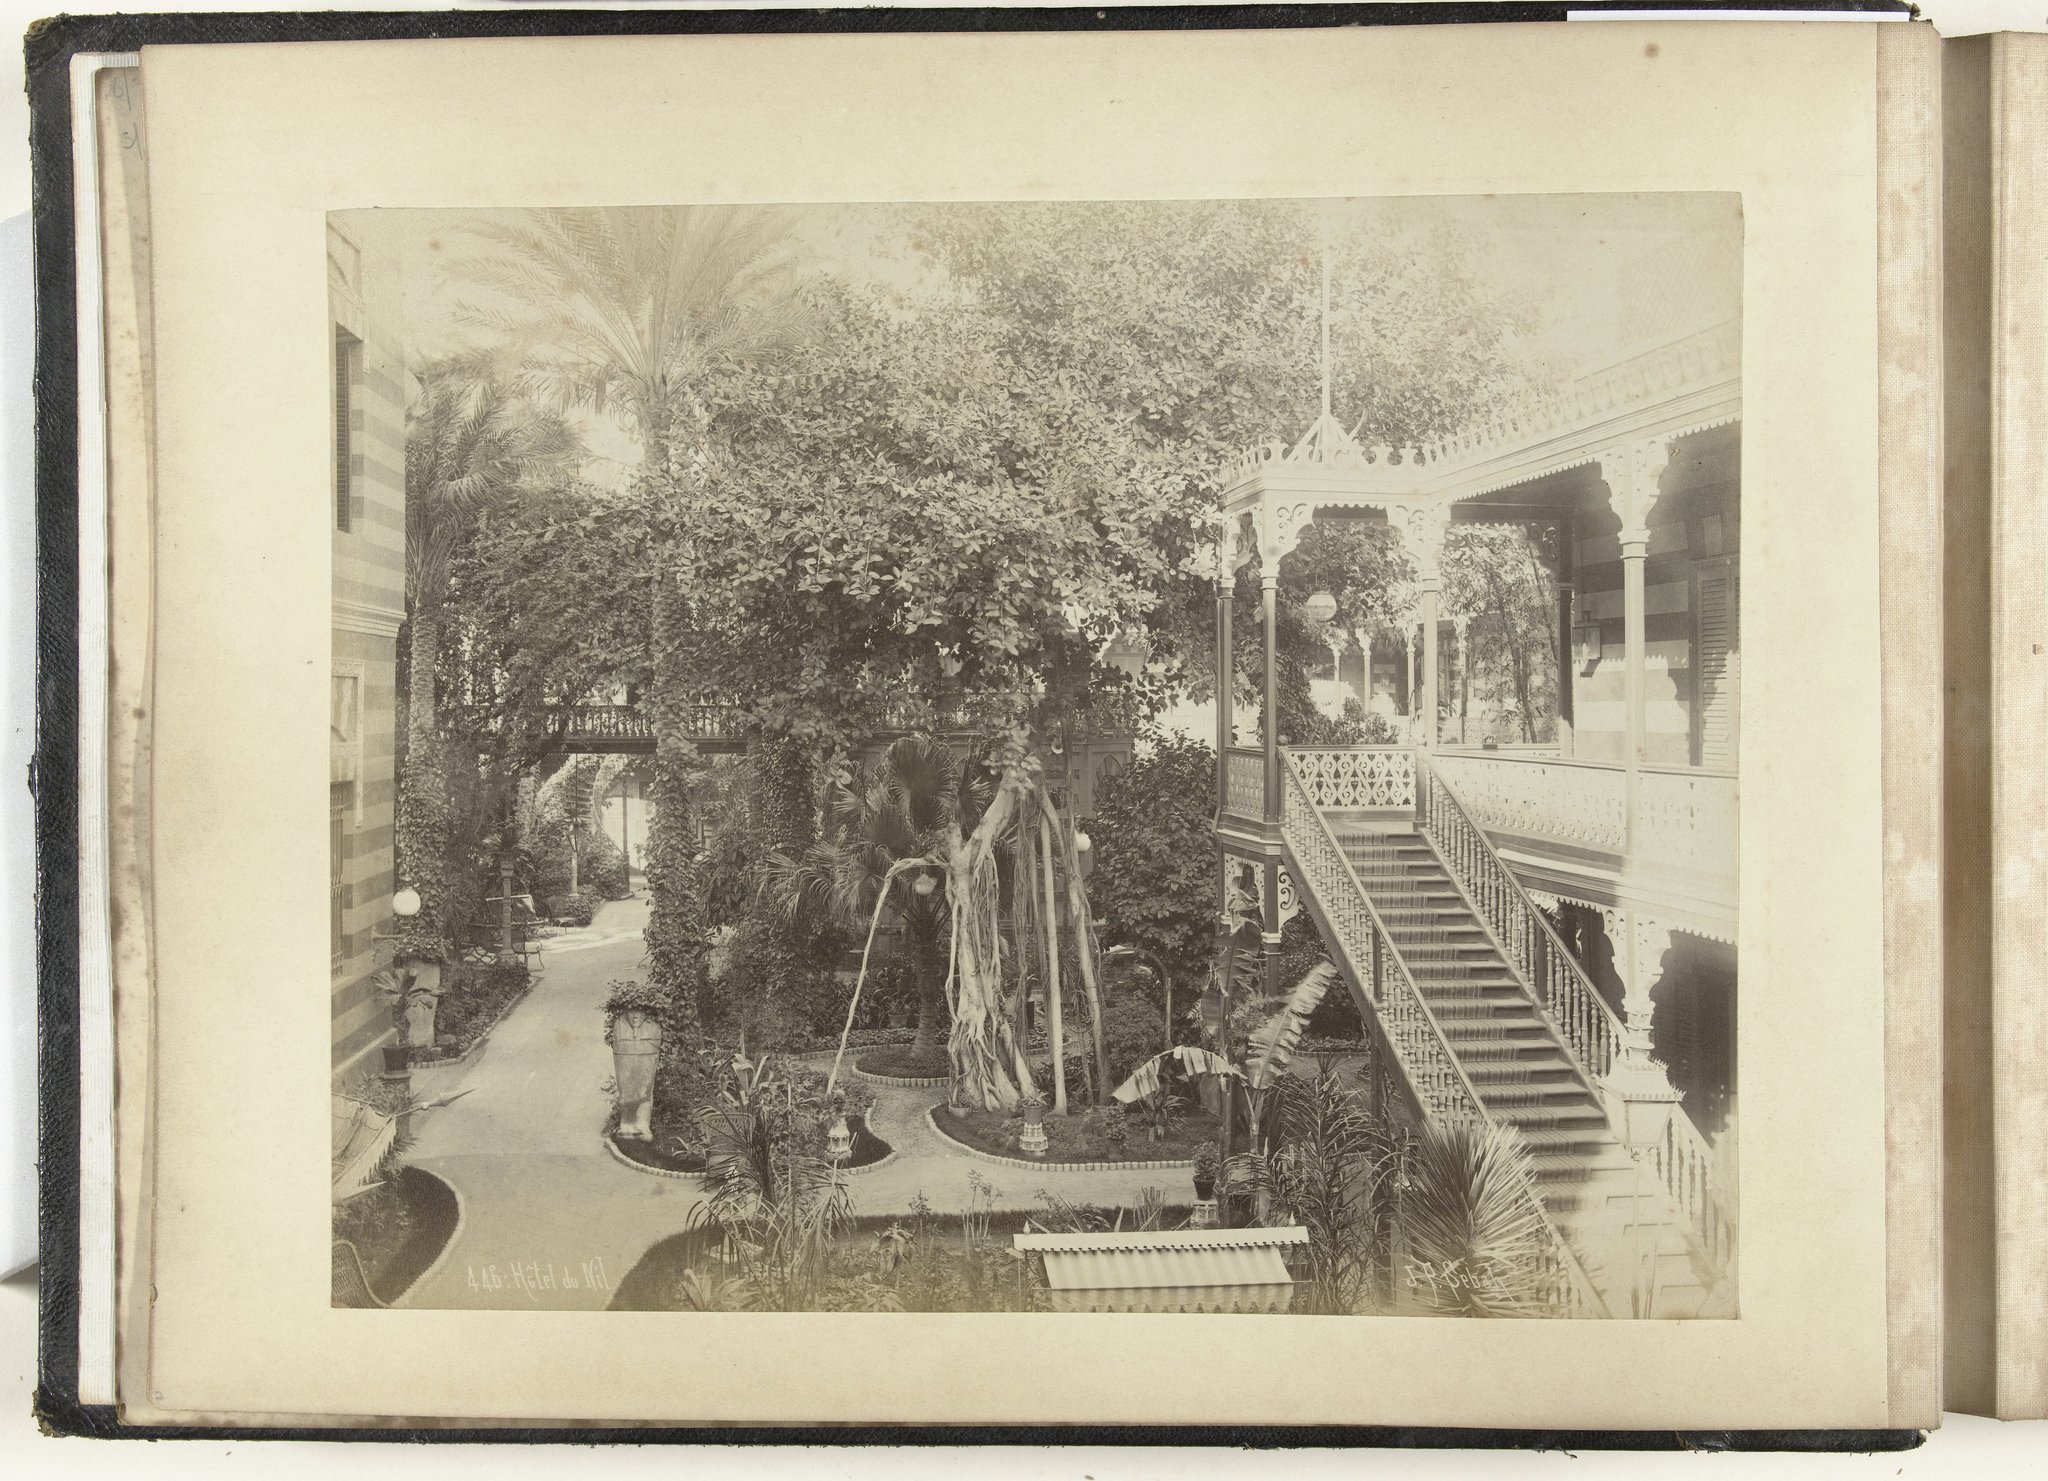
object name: photograph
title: Hotel du Nil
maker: pascal sébah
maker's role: fotograaf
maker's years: 1823-1886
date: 1873-1886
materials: paper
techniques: albumen print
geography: cairo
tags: courtyard, hotel, hostelry, inn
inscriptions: number: ‘446’